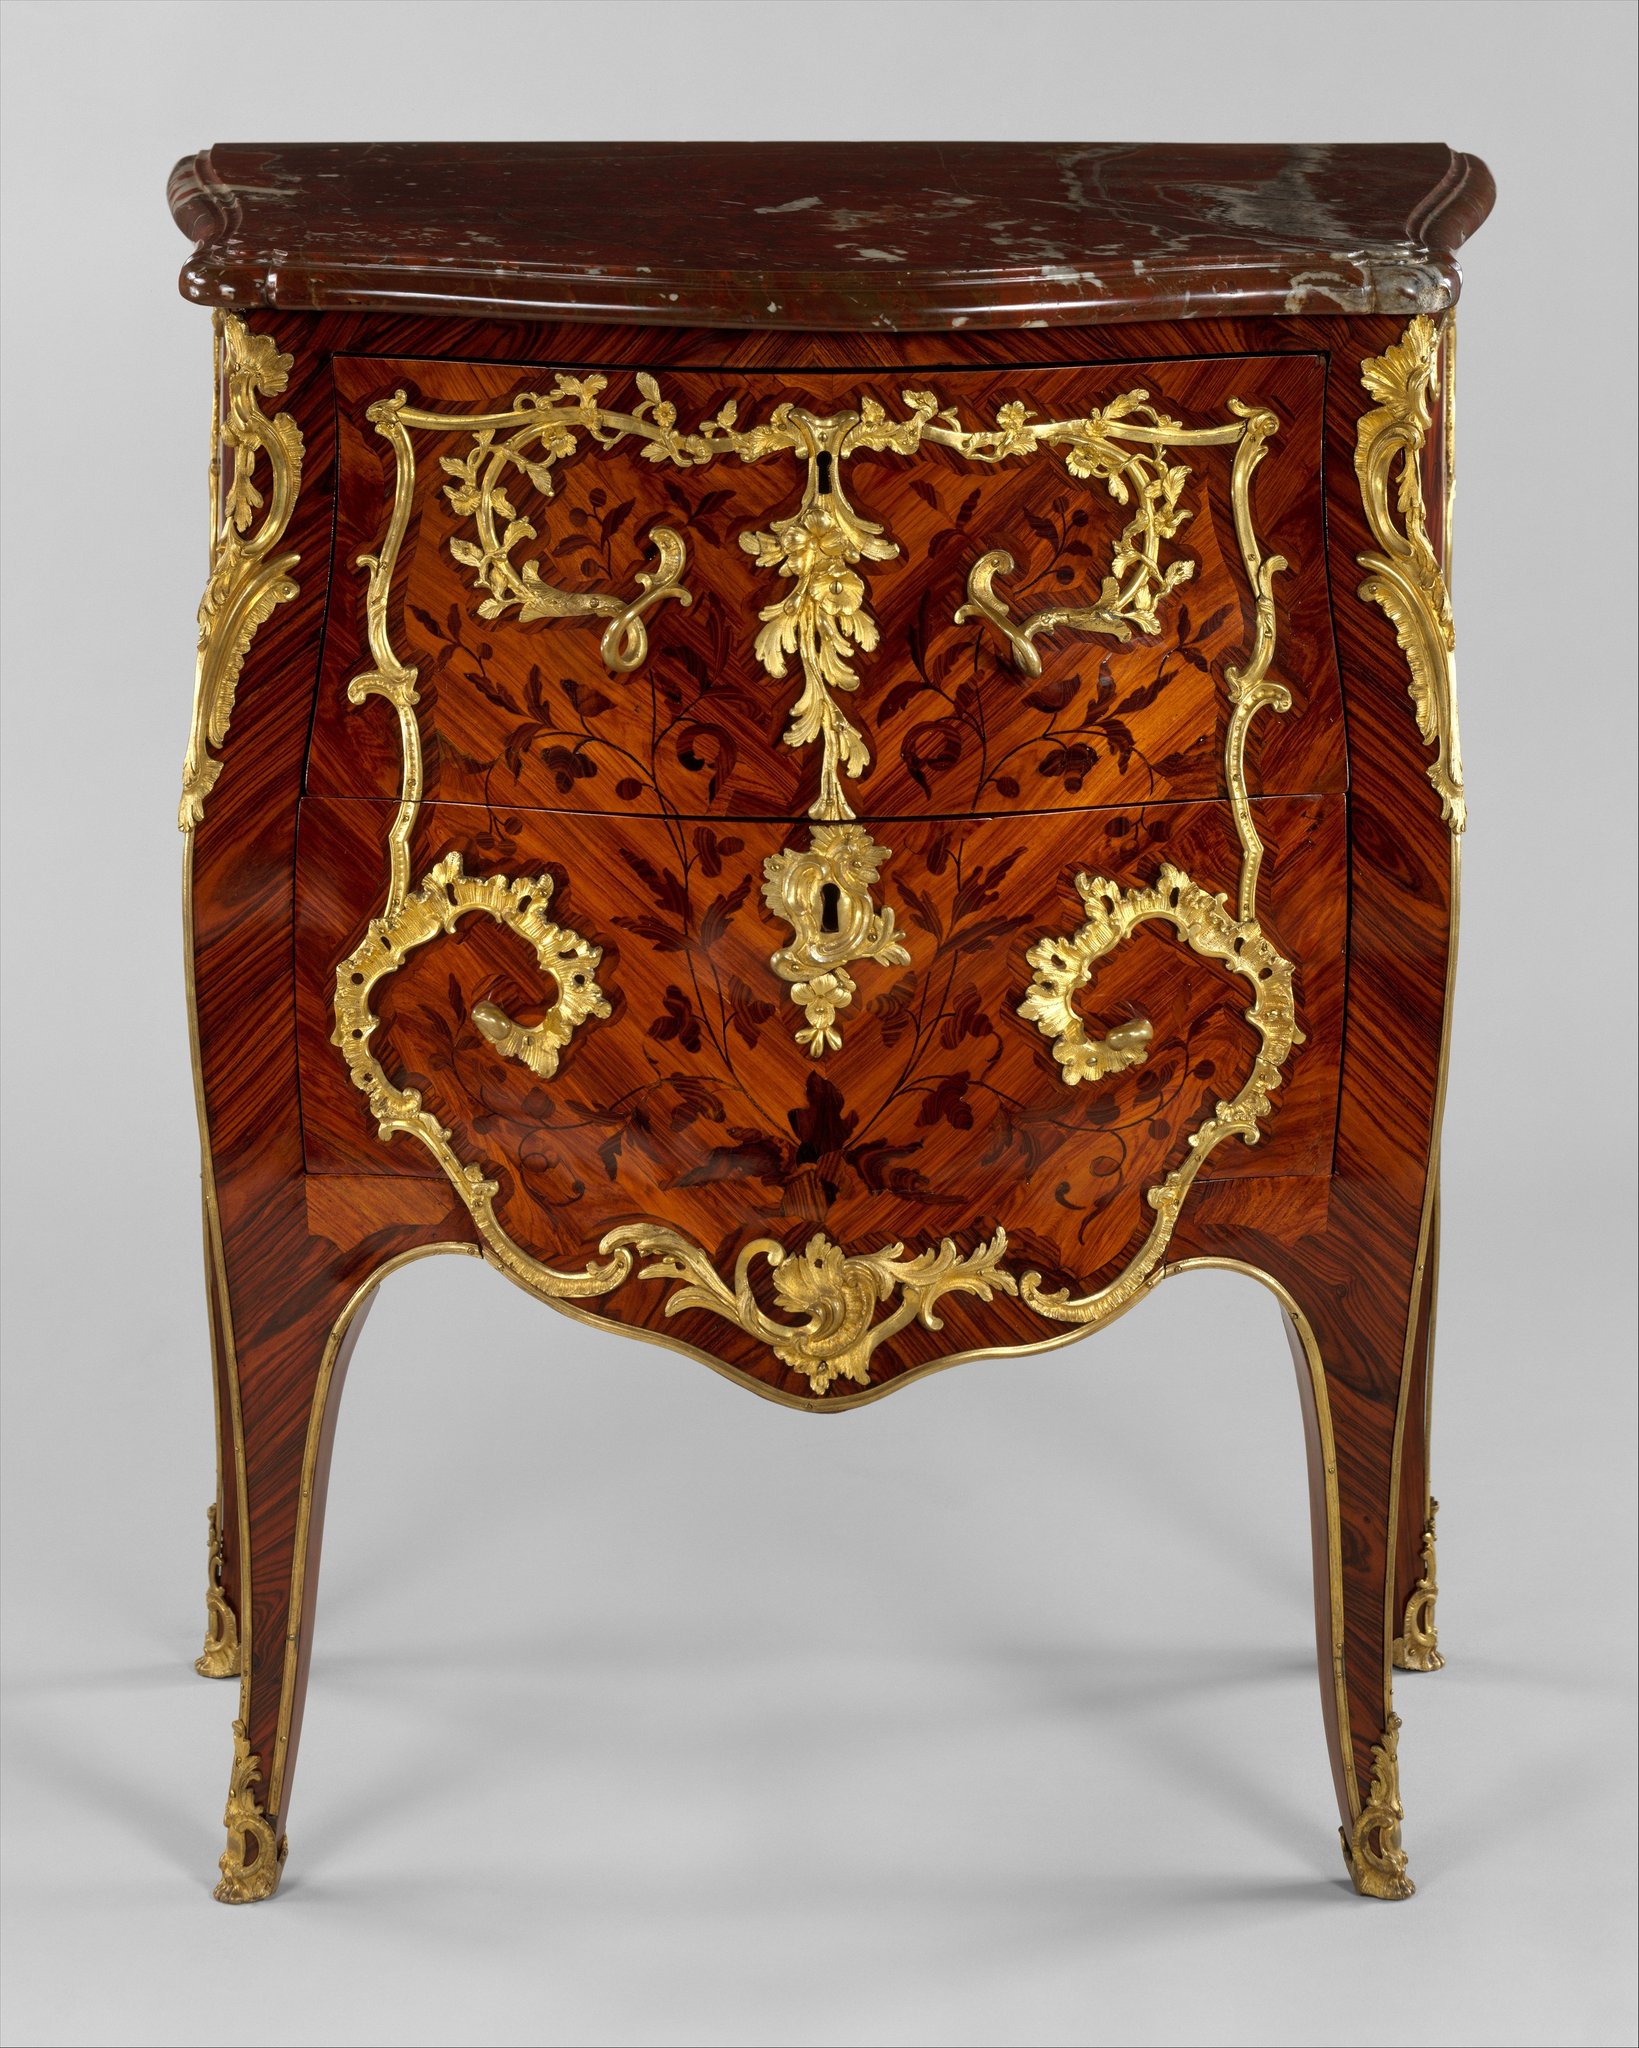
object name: commode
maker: roger vandercruse, called lacroix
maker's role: maker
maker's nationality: french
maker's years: 1727-1799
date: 1755-1760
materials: gilt bronze, marble, wood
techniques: cutting, veneering